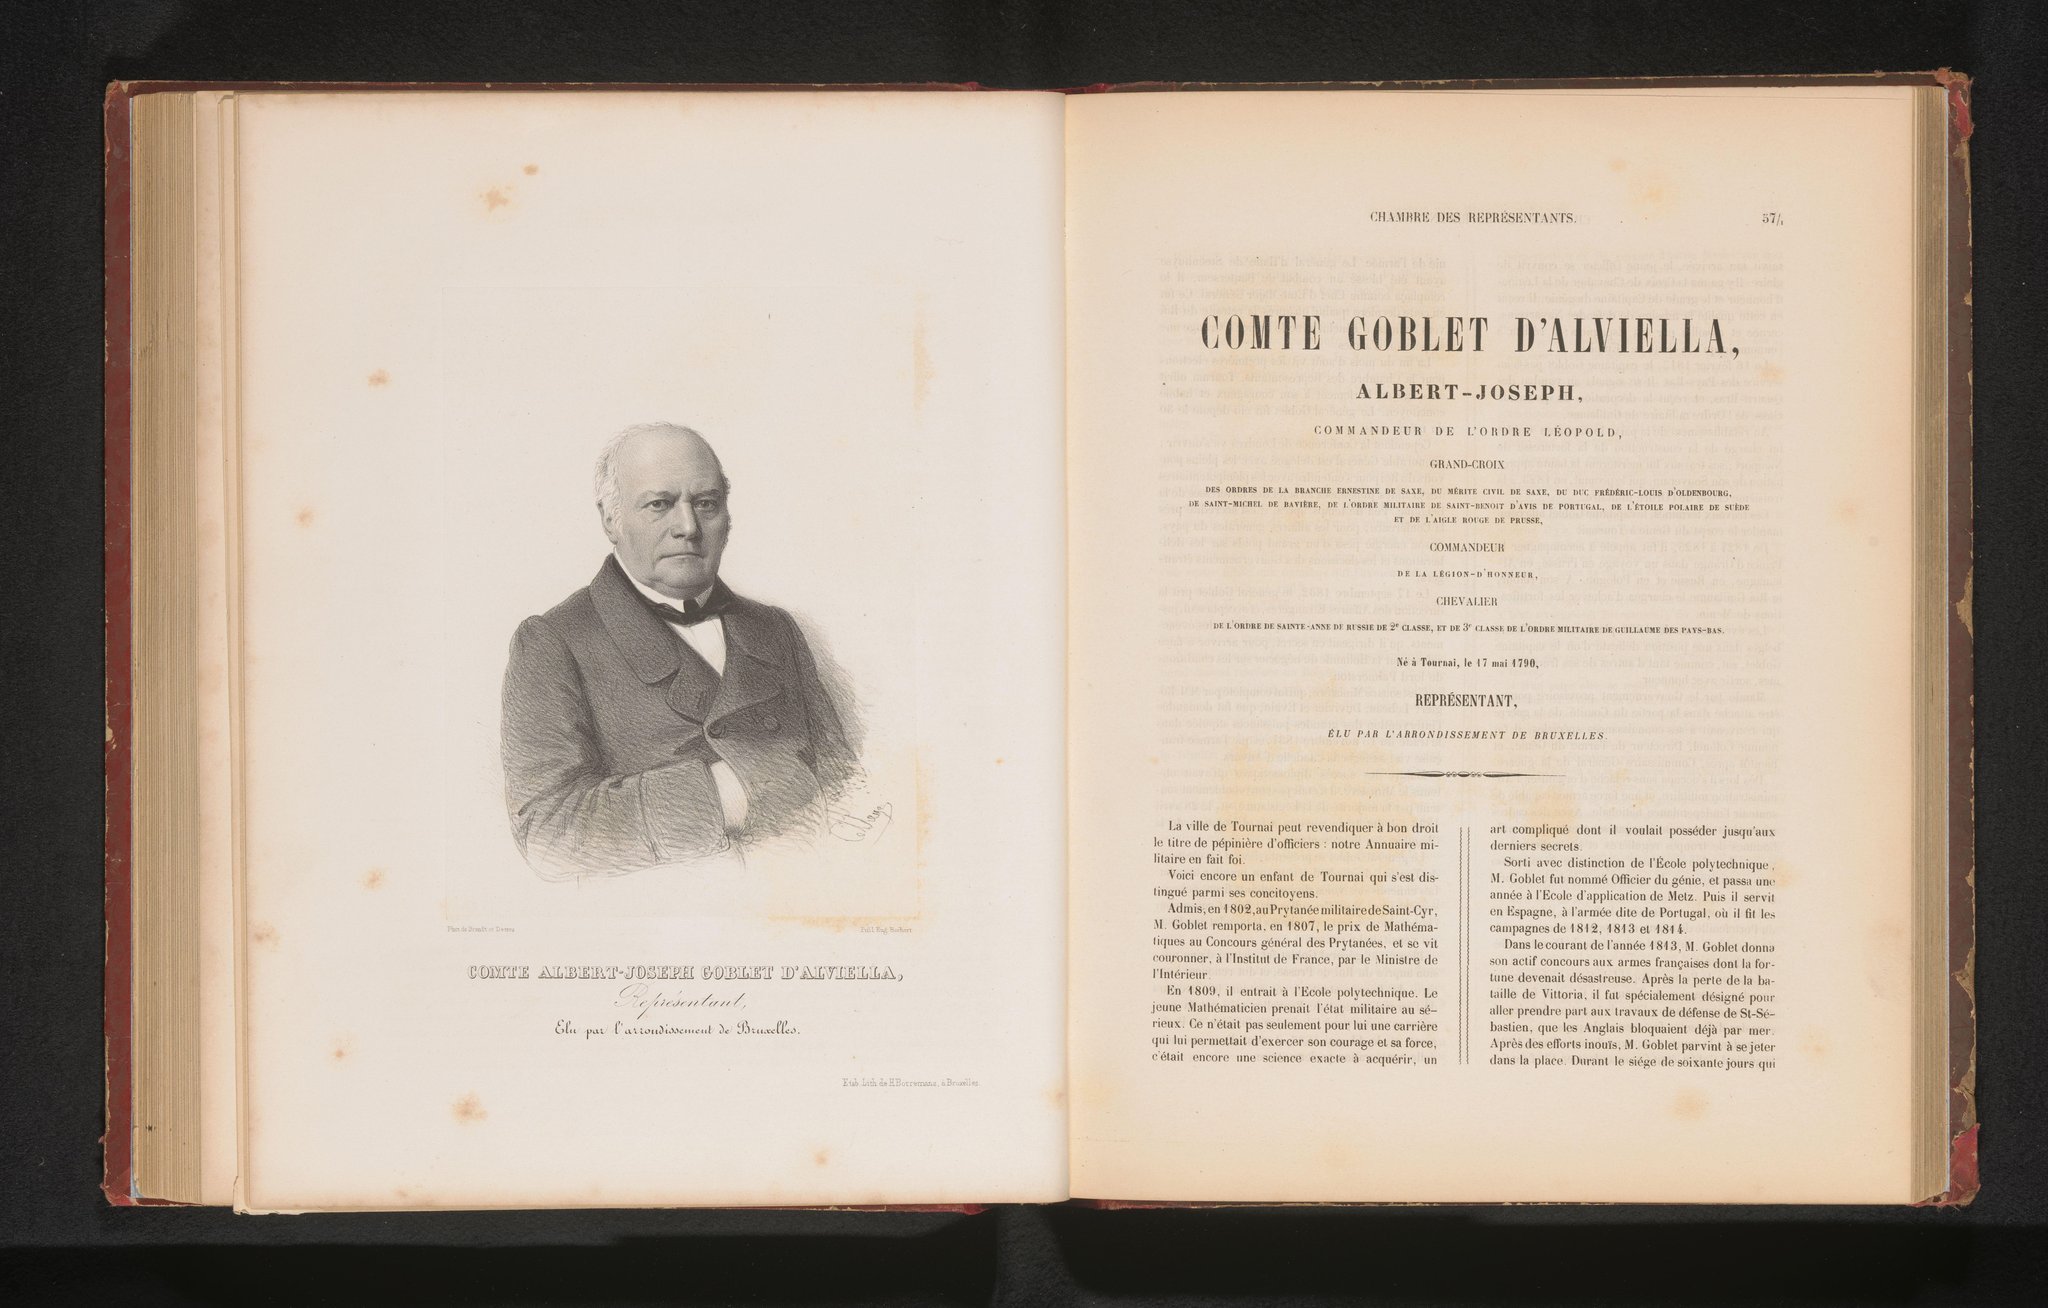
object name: page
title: Comte Albert-Joseph Goblet d'Alviella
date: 1853-1858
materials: paper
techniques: lithograph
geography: brussels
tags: politician, historical persons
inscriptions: inscription: ‘Représentant,/ Elu par l'arrondissement de Bruxelles.’